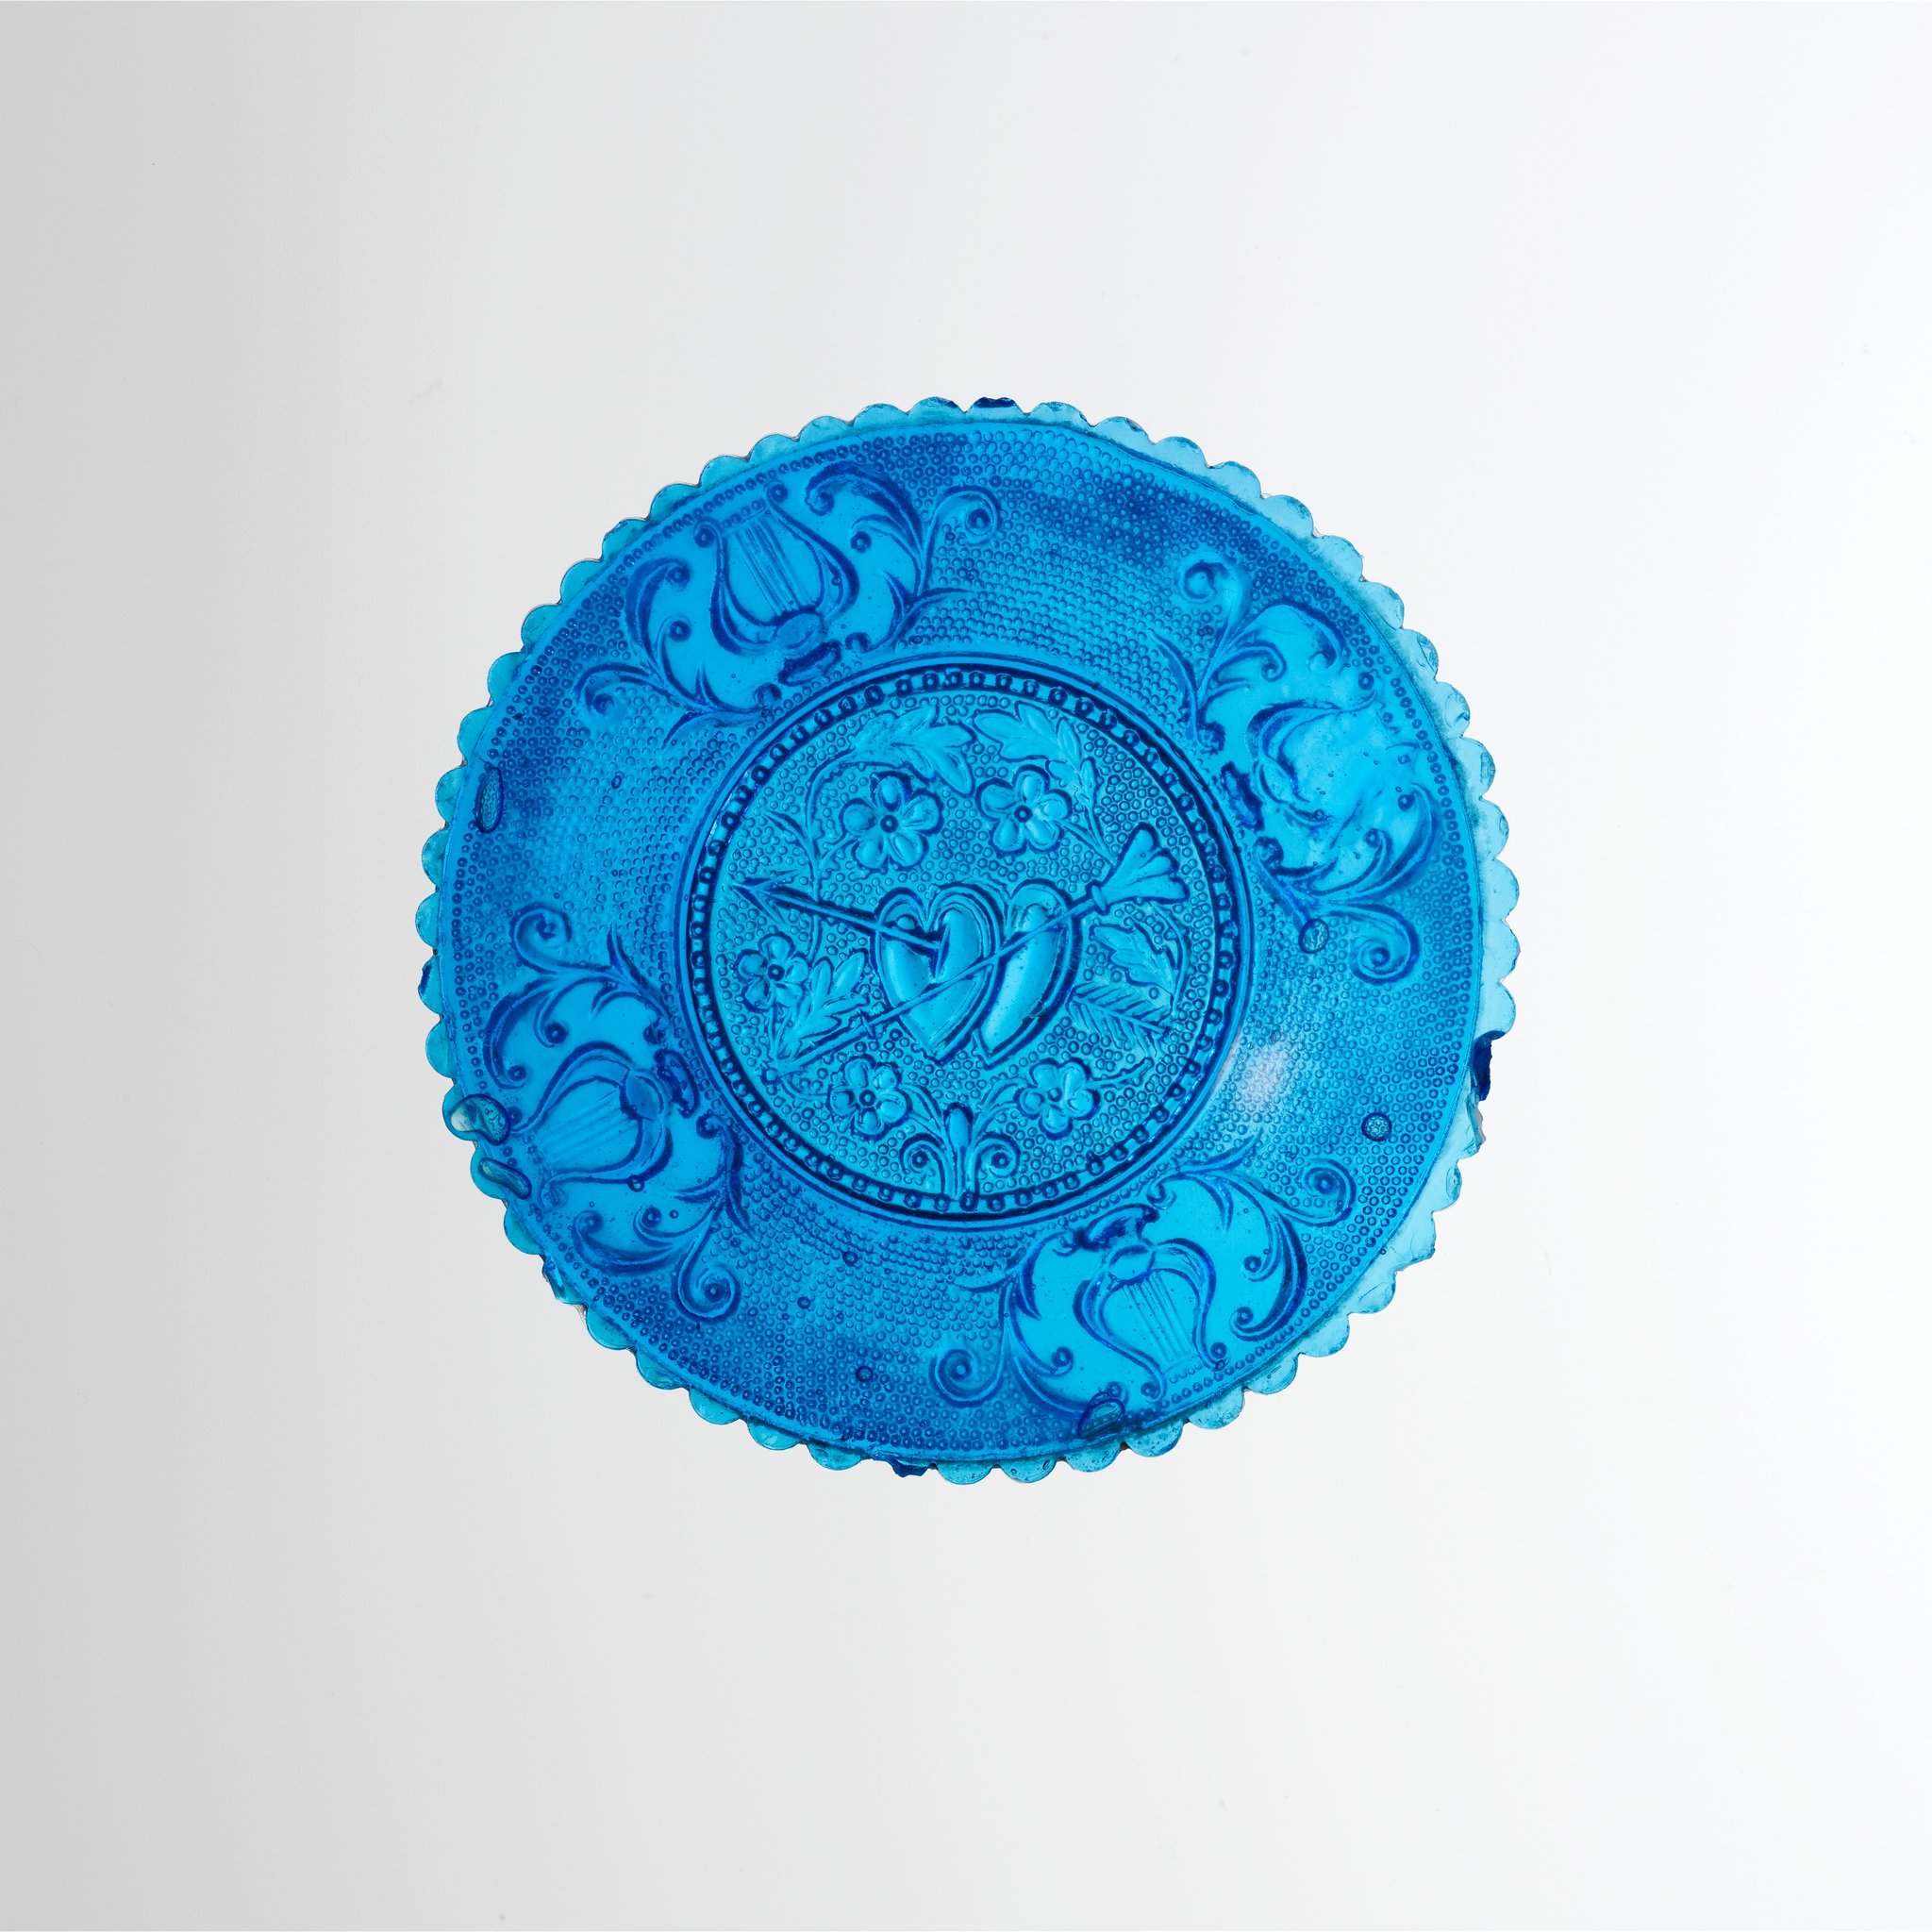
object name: cup plate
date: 1825-1860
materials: glass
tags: arrows,lyres